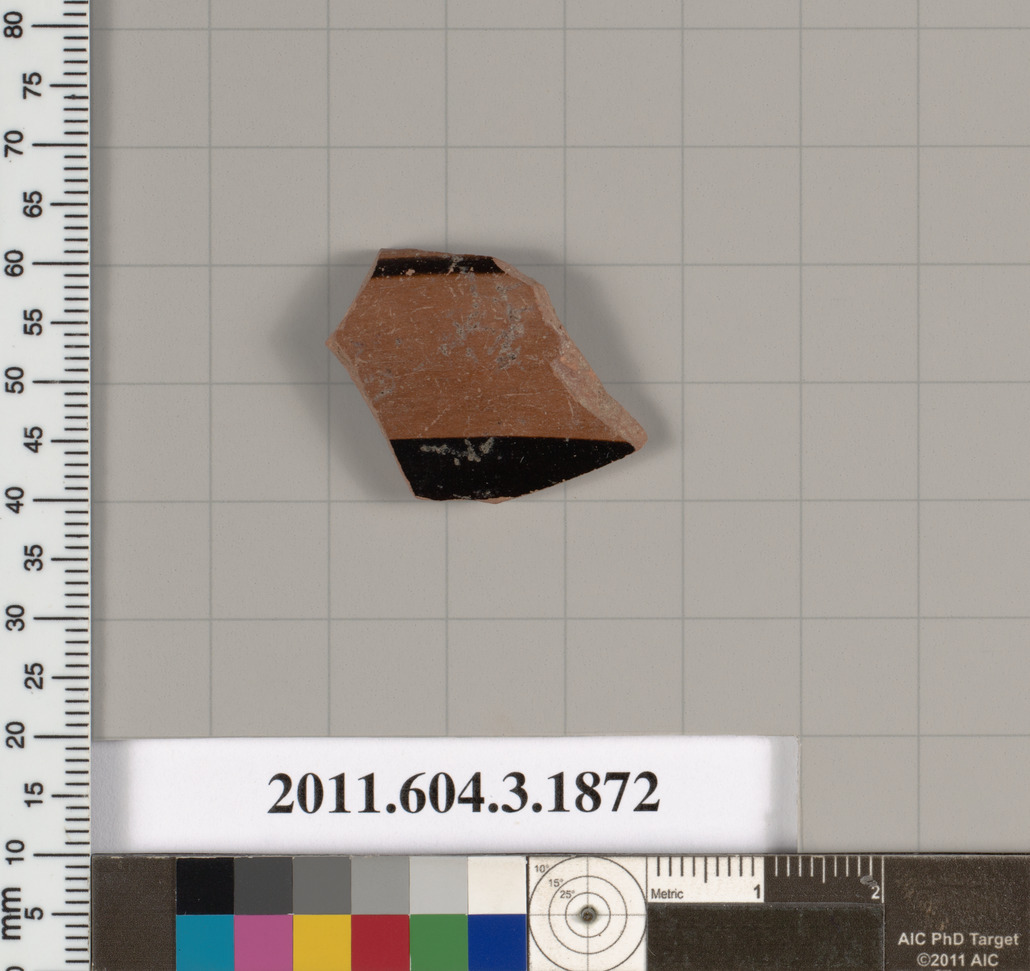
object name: kylix fragment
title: Terracotta fragment of a kylix: Band or lip cup (drinking cup)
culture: greek, attic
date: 560-525 BCE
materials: terracotta